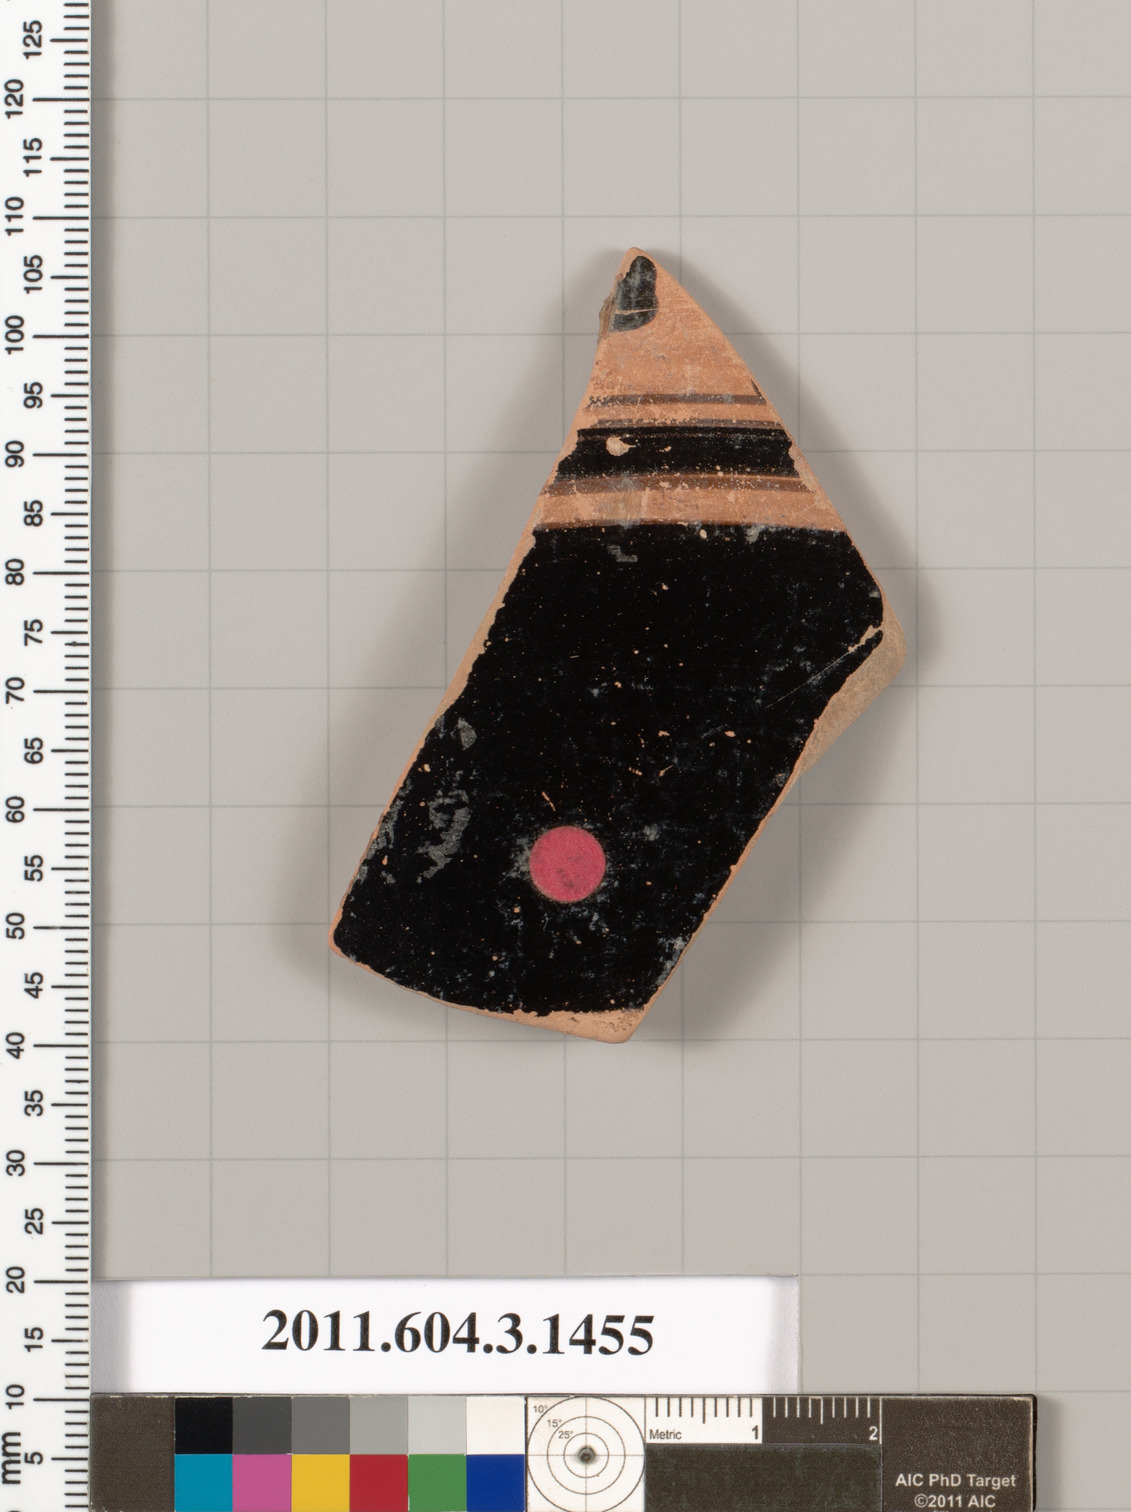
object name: skyphos fragment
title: Terracotta fragment of a skyphos (deep drinking cup)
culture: greek, attic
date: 534-468 BCE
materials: terracotta